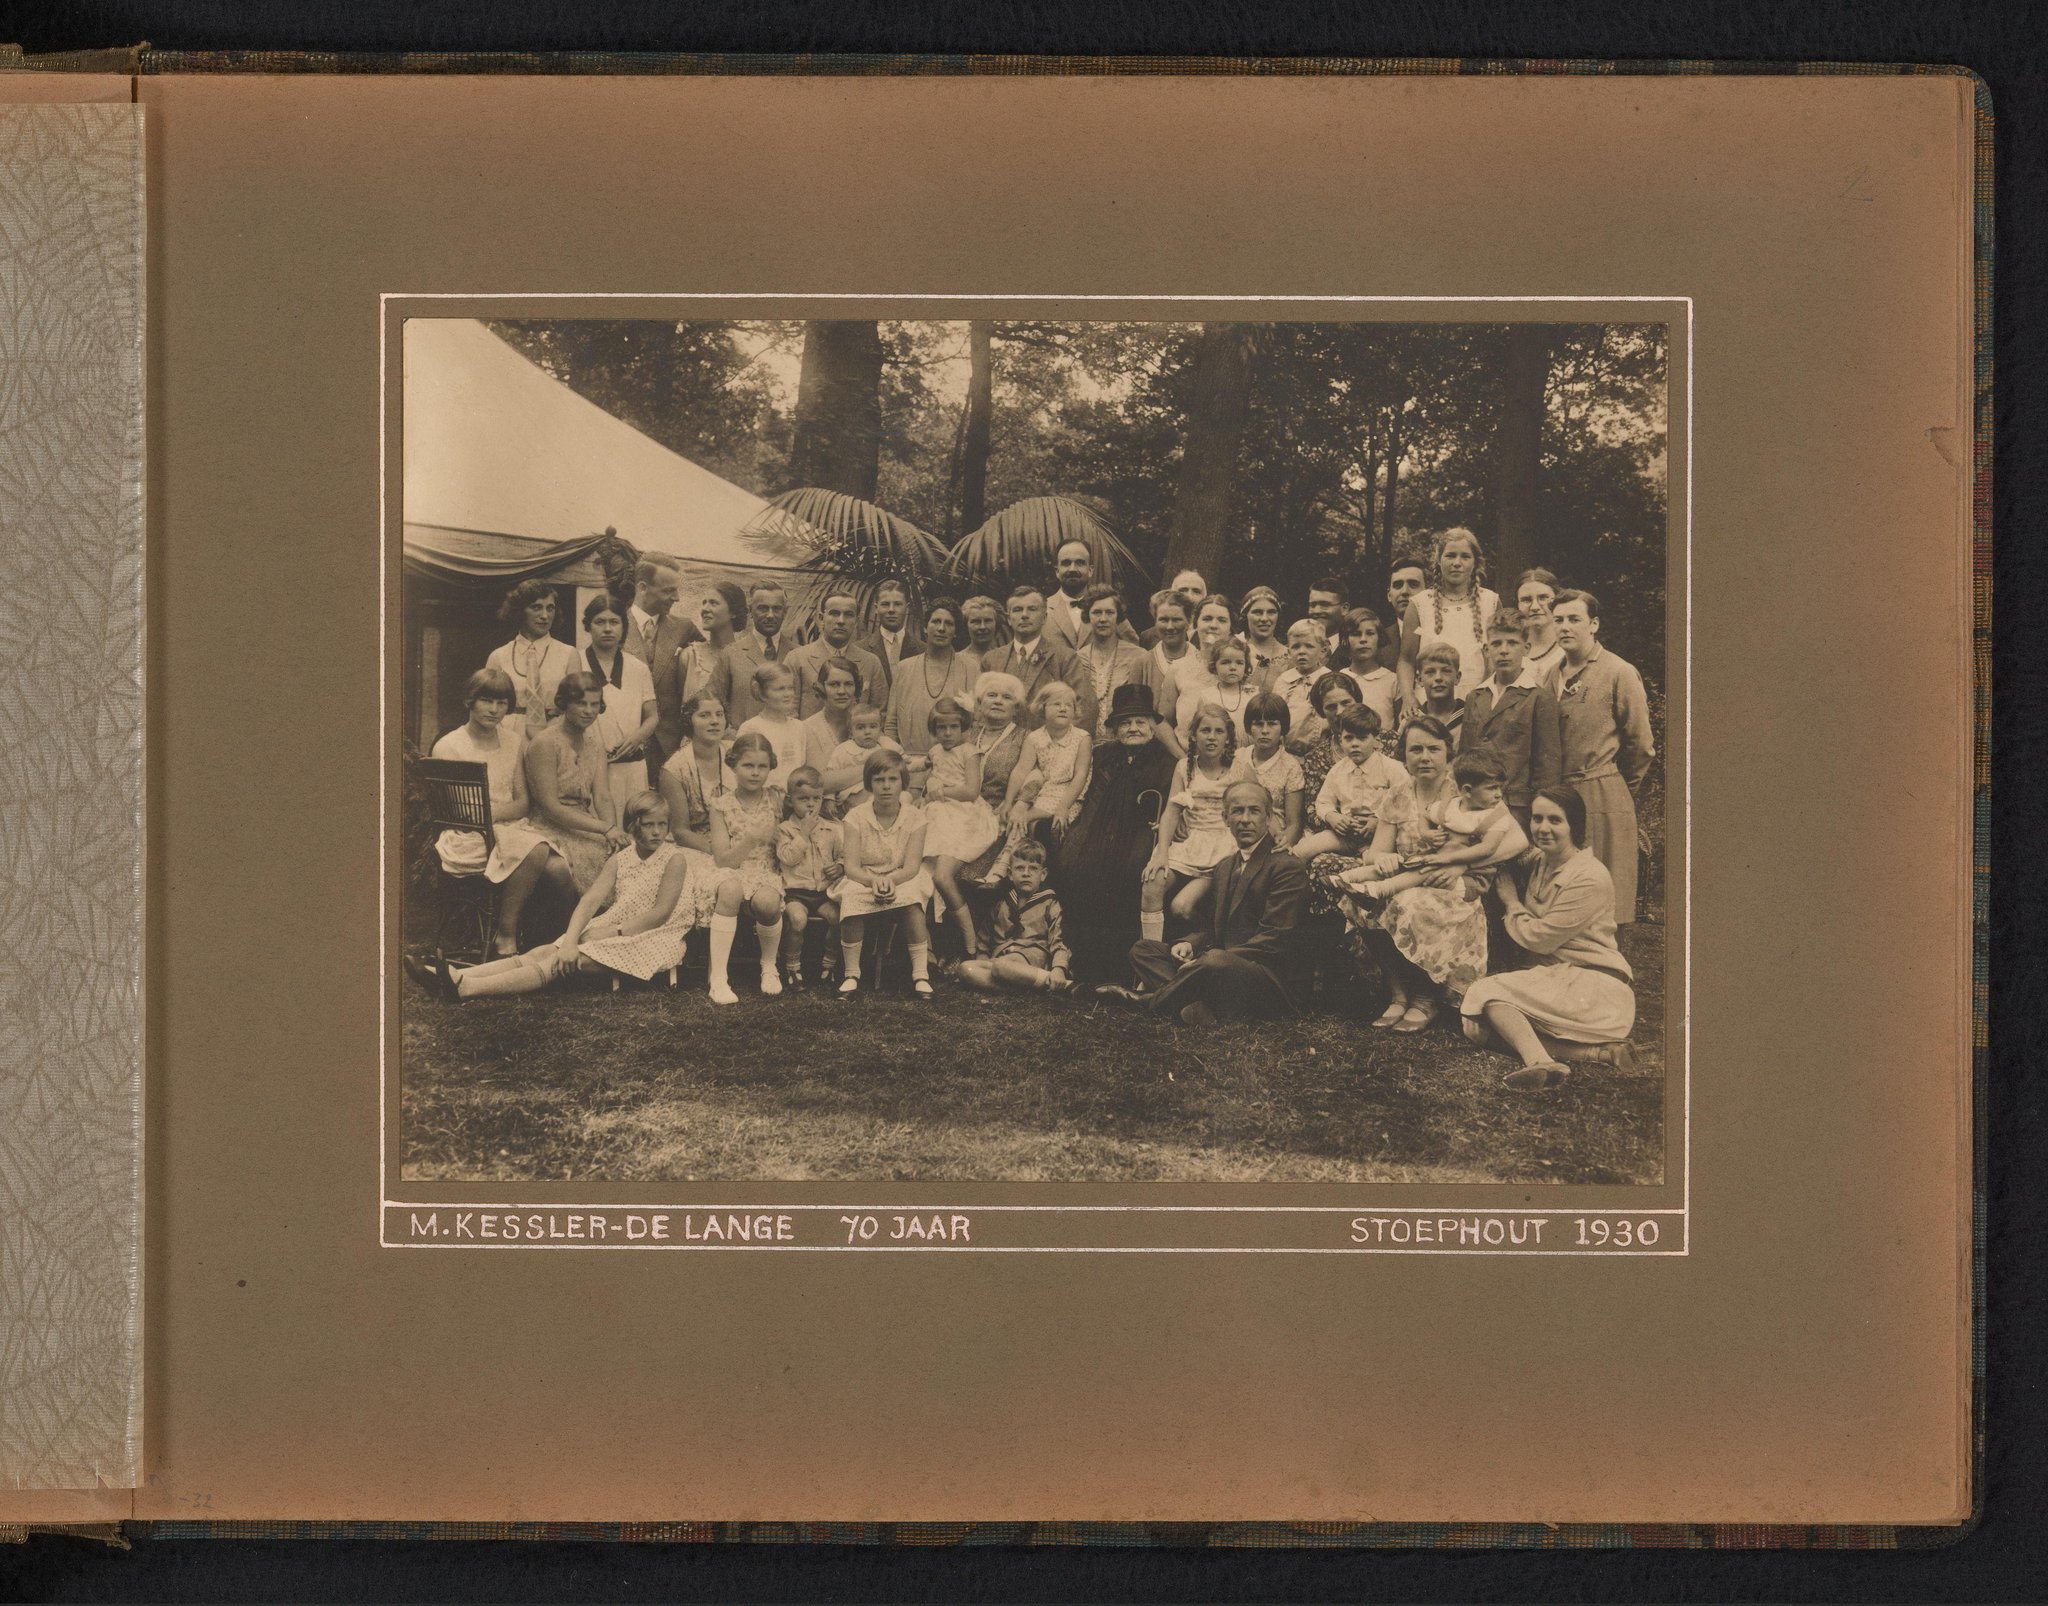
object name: album leaf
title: Familieportret ter gelegenheid van de 70e verjaardag van Margo Kessler-de Lange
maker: Anonymous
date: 1930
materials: paper, cardboard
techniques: gelatin silver print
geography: wassenaar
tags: margaretha jacoba johanna kessler-de lange (margo), historical persons, festivities